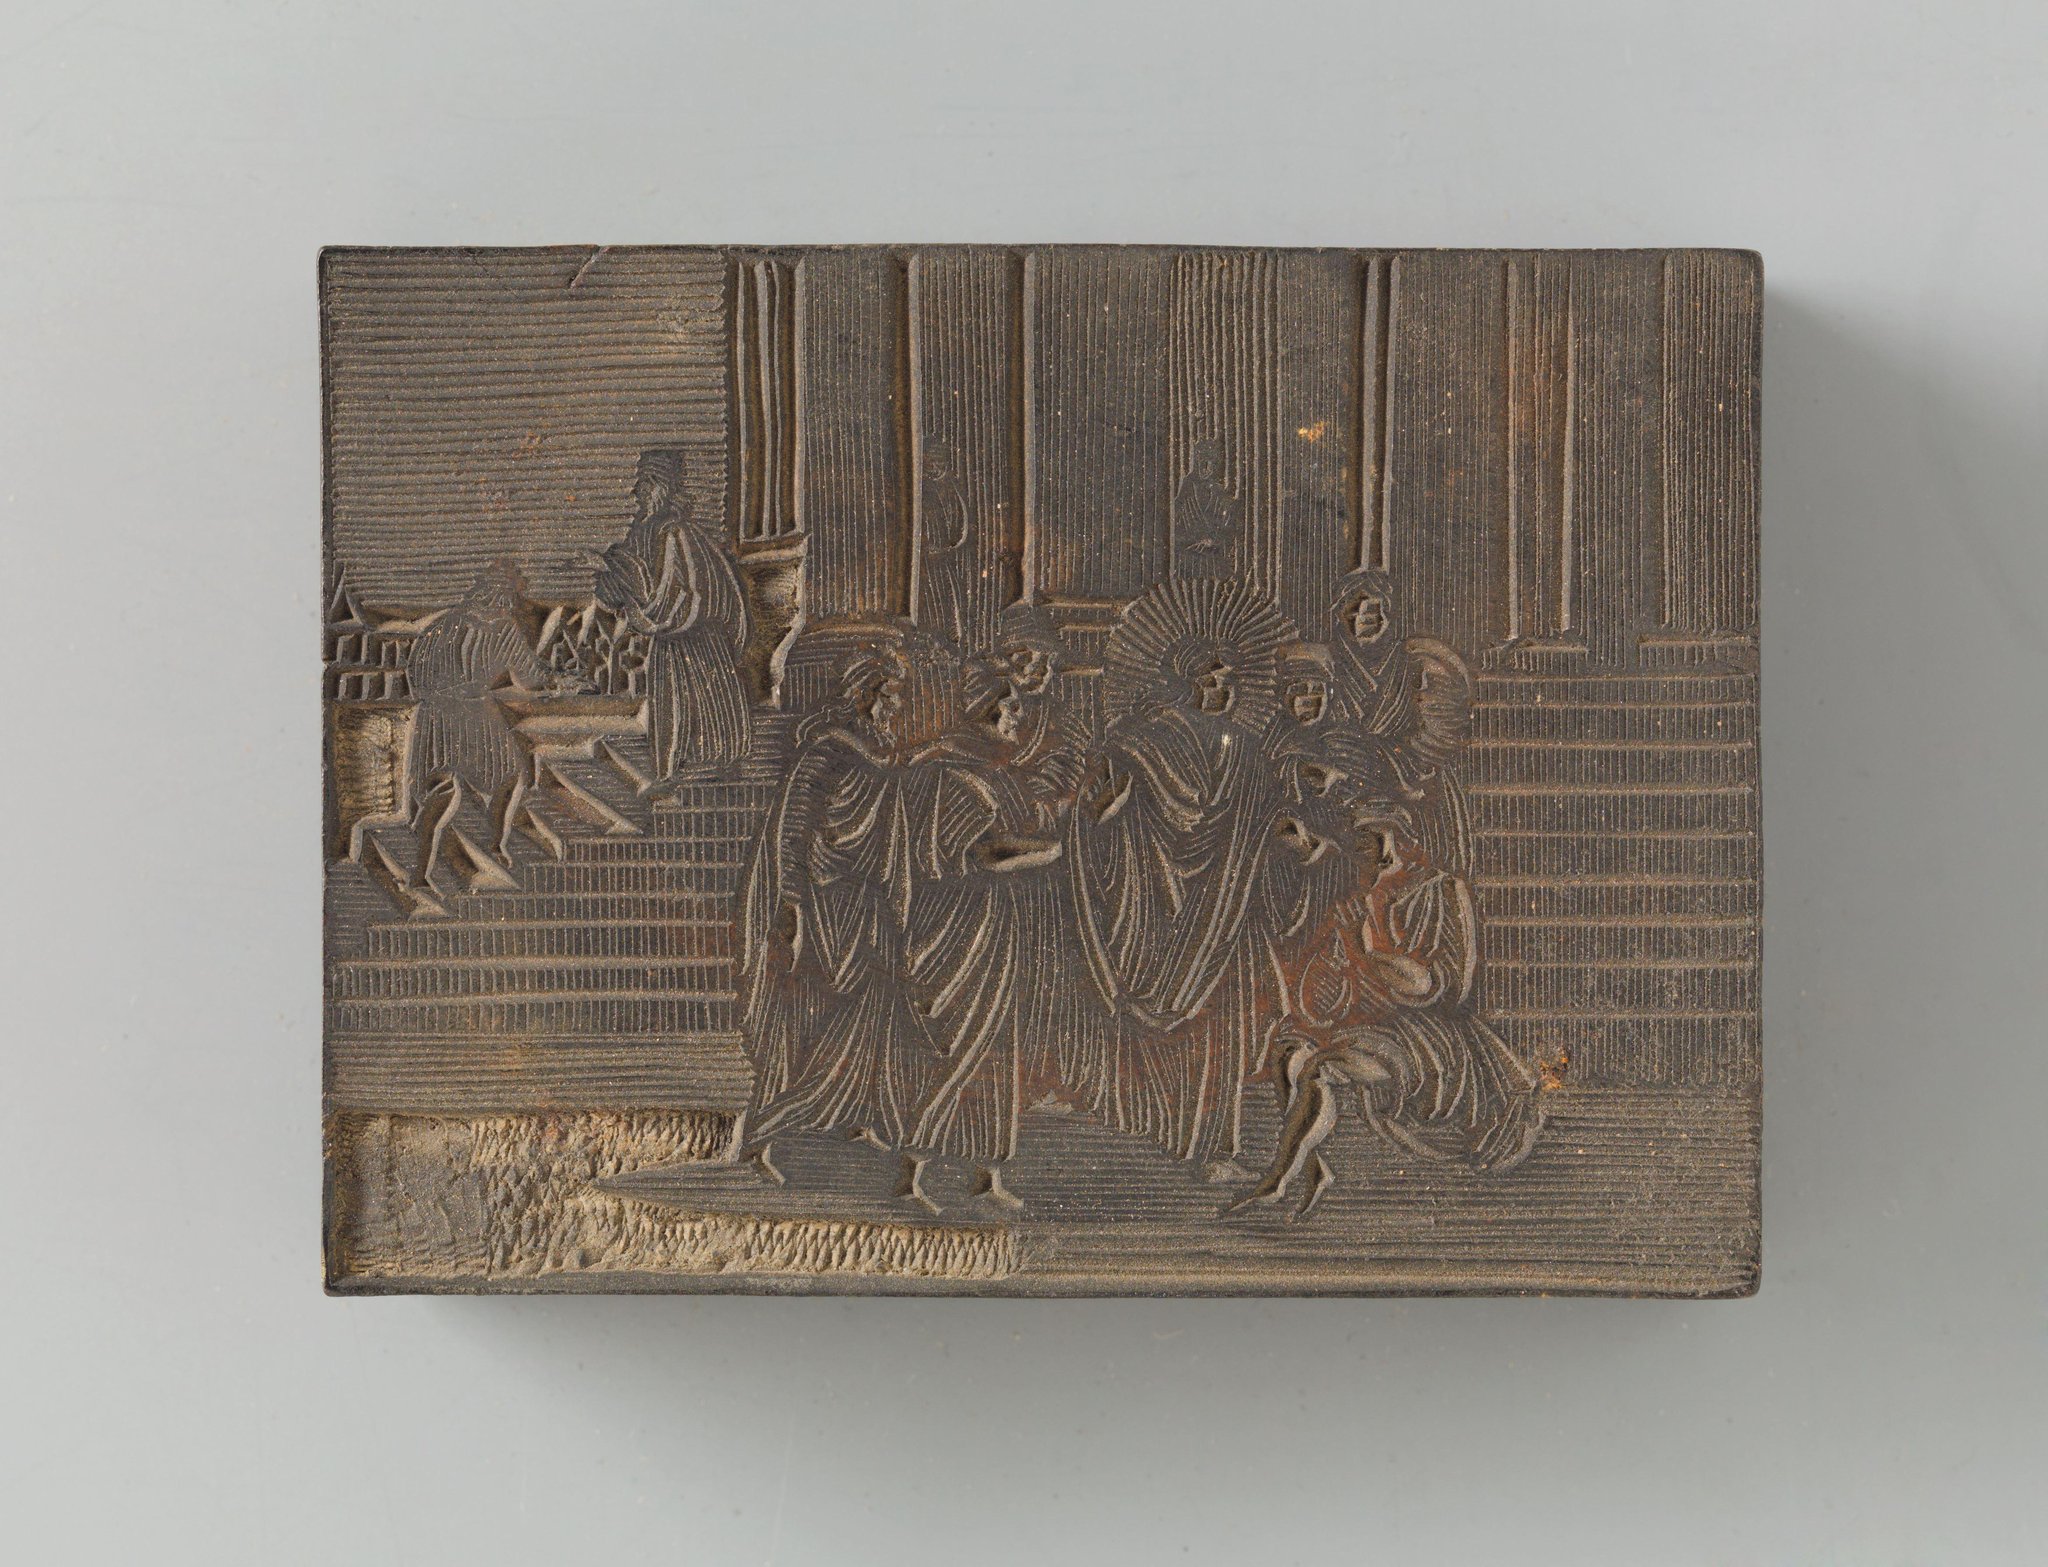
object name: wood block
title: Bijbel-illustraties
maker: Anonymous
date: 1550-1699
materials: wood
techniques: woodcut